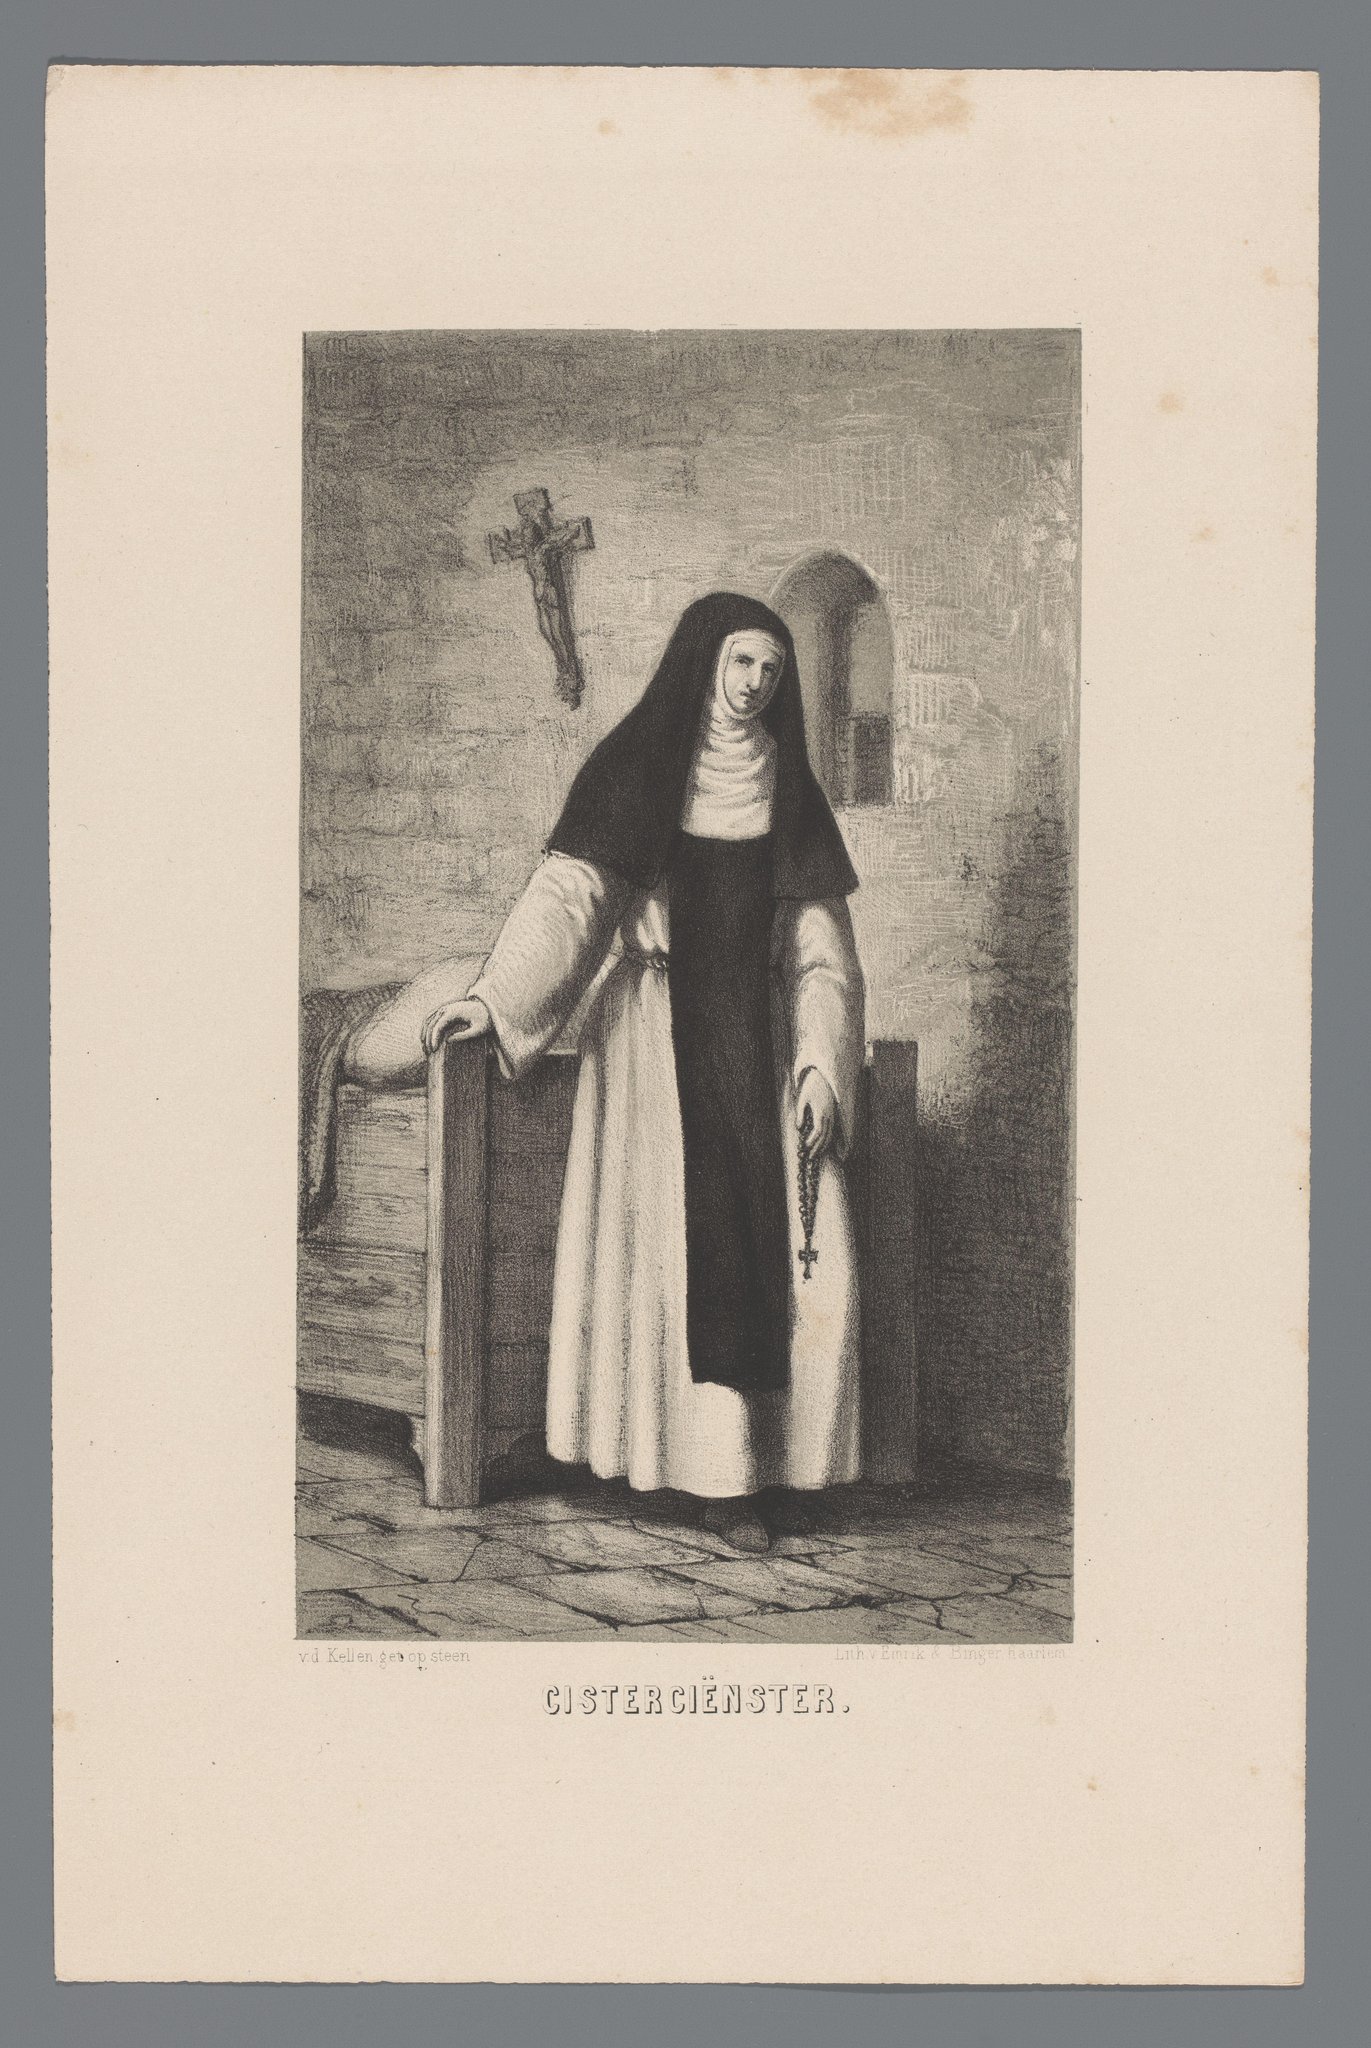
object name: print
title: Cisterciënzer non in haar cel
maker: david van der kellen (1827-1895)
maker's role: draughtsman, print maker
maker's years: 1827-1895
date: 1865-1874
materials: paper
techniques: tone lithography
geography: the hague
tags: nun(s), cell ~ monastery, crucifix ~ personal devotion, monastic orders, monastic life: cistercians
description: Prent waarschijnlijk uit: Hofdijk, W.J. De klooster-orden in Nederland. Haarlem: A.C. Kruseman, 1865. Of uit de editie van 1874.